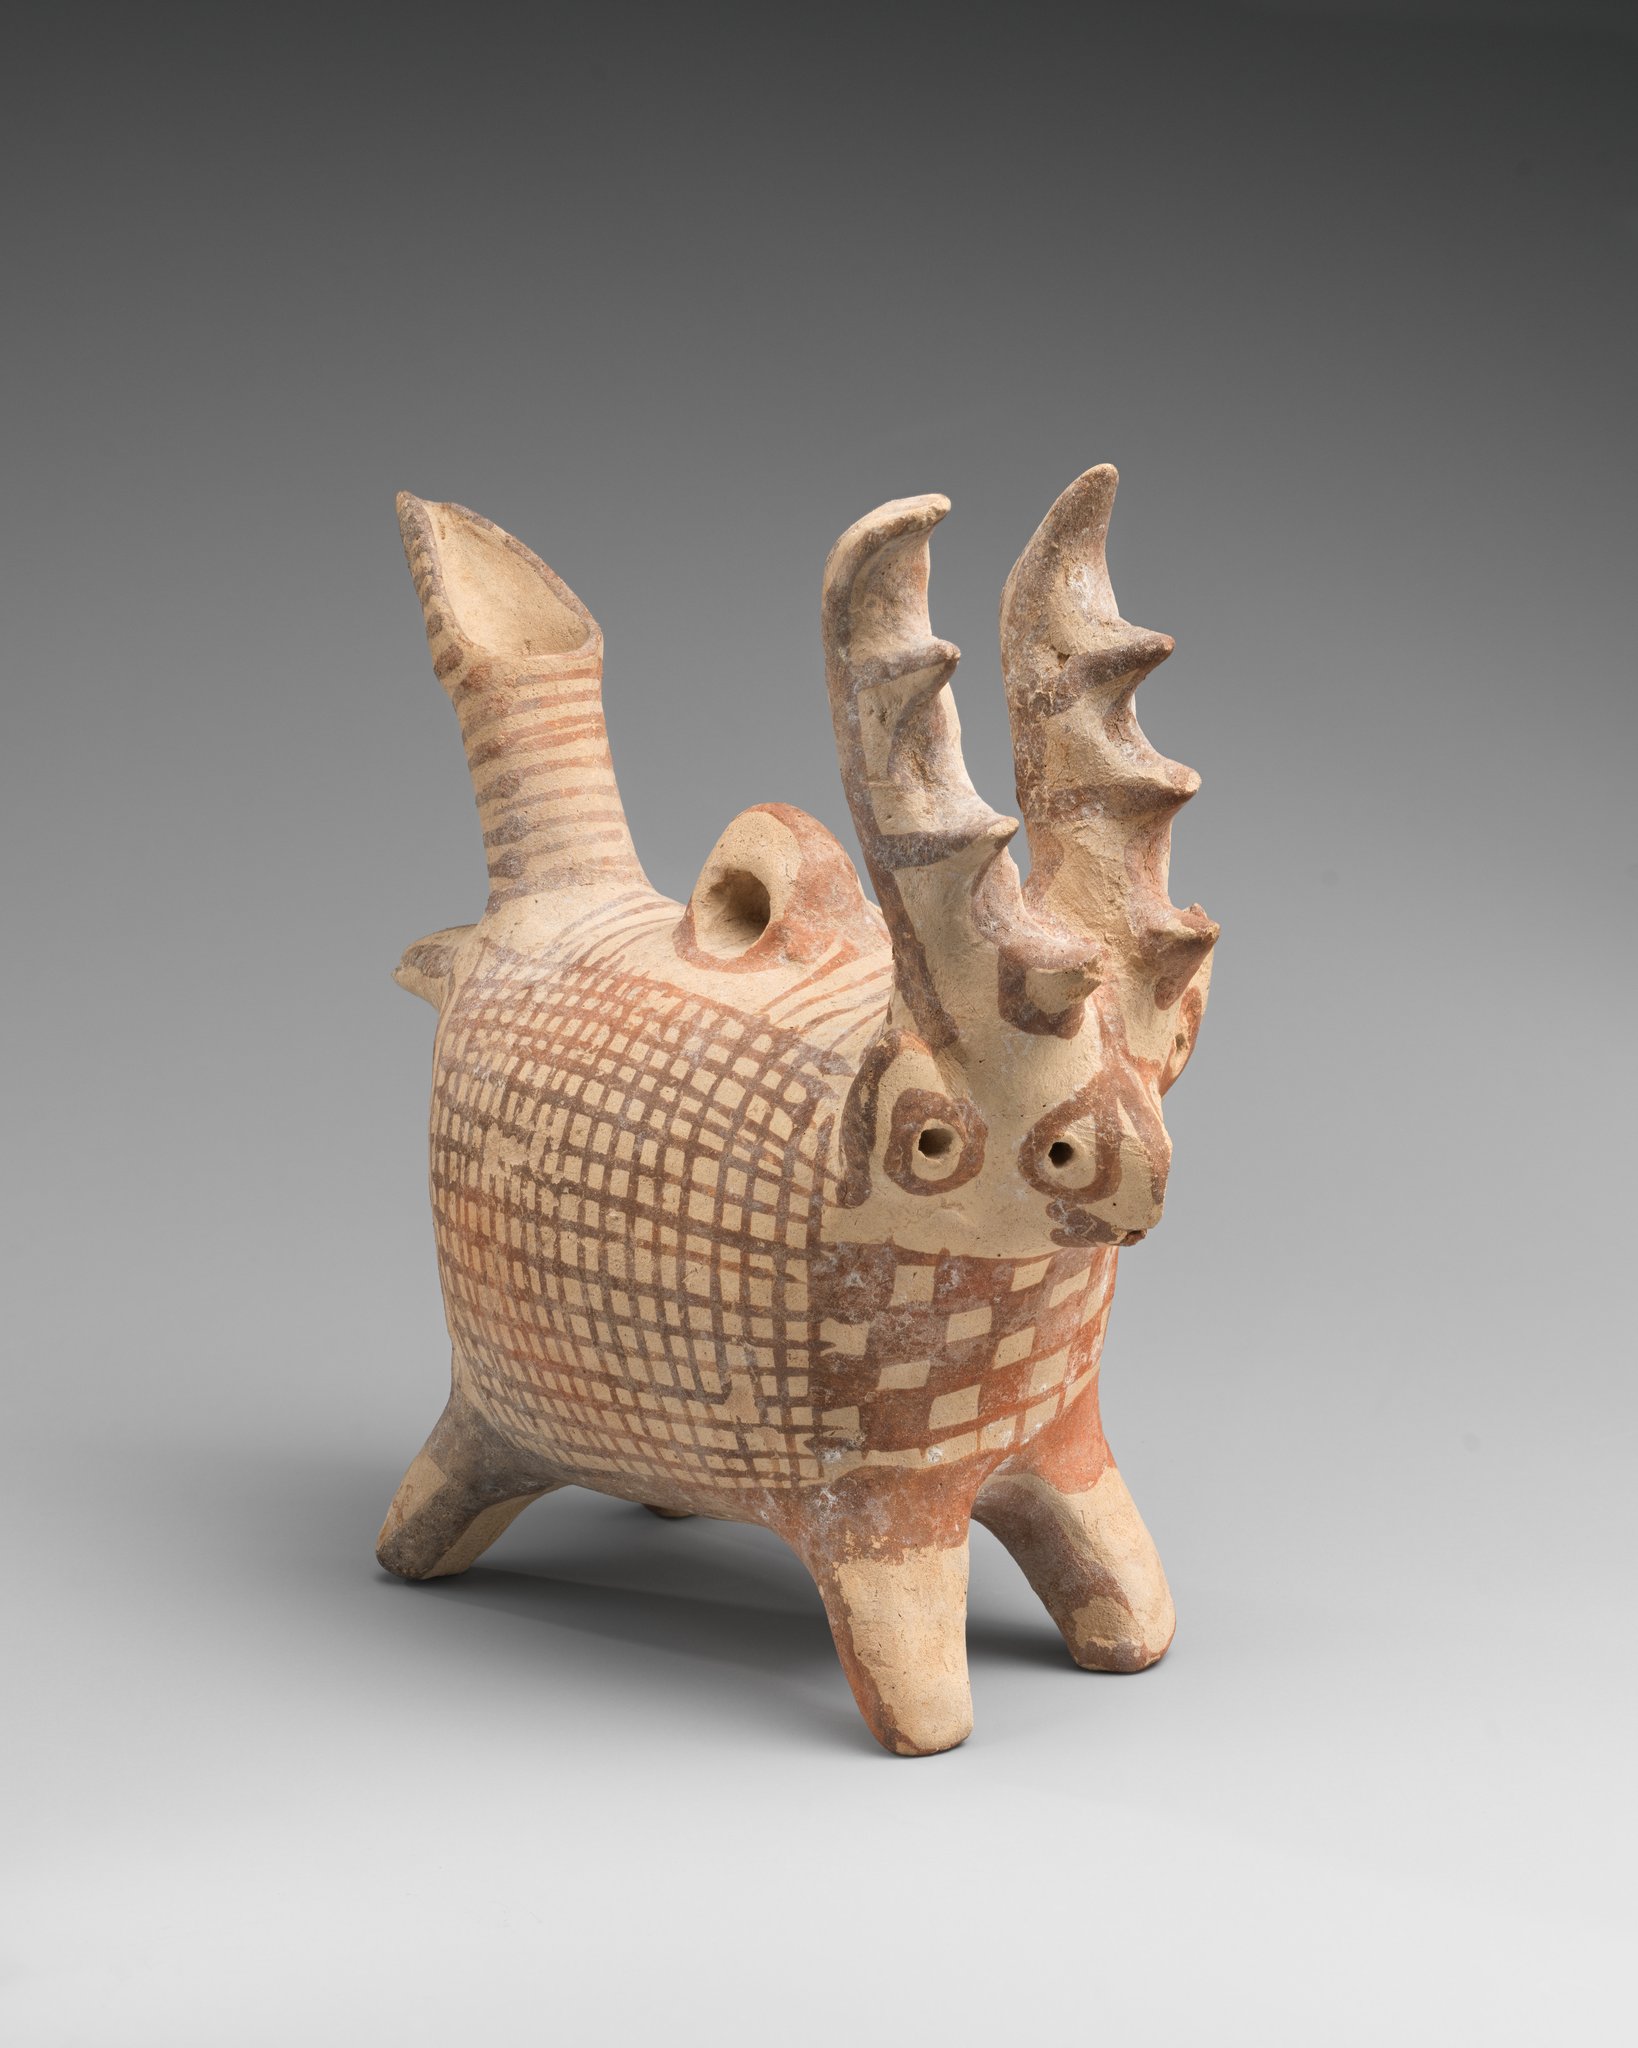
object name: askos in the form of an animal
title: Terracotta zoomorphic askos (vessel) with antlers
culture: cypriot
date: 1725-1600 BCE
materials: terracotta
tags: deer